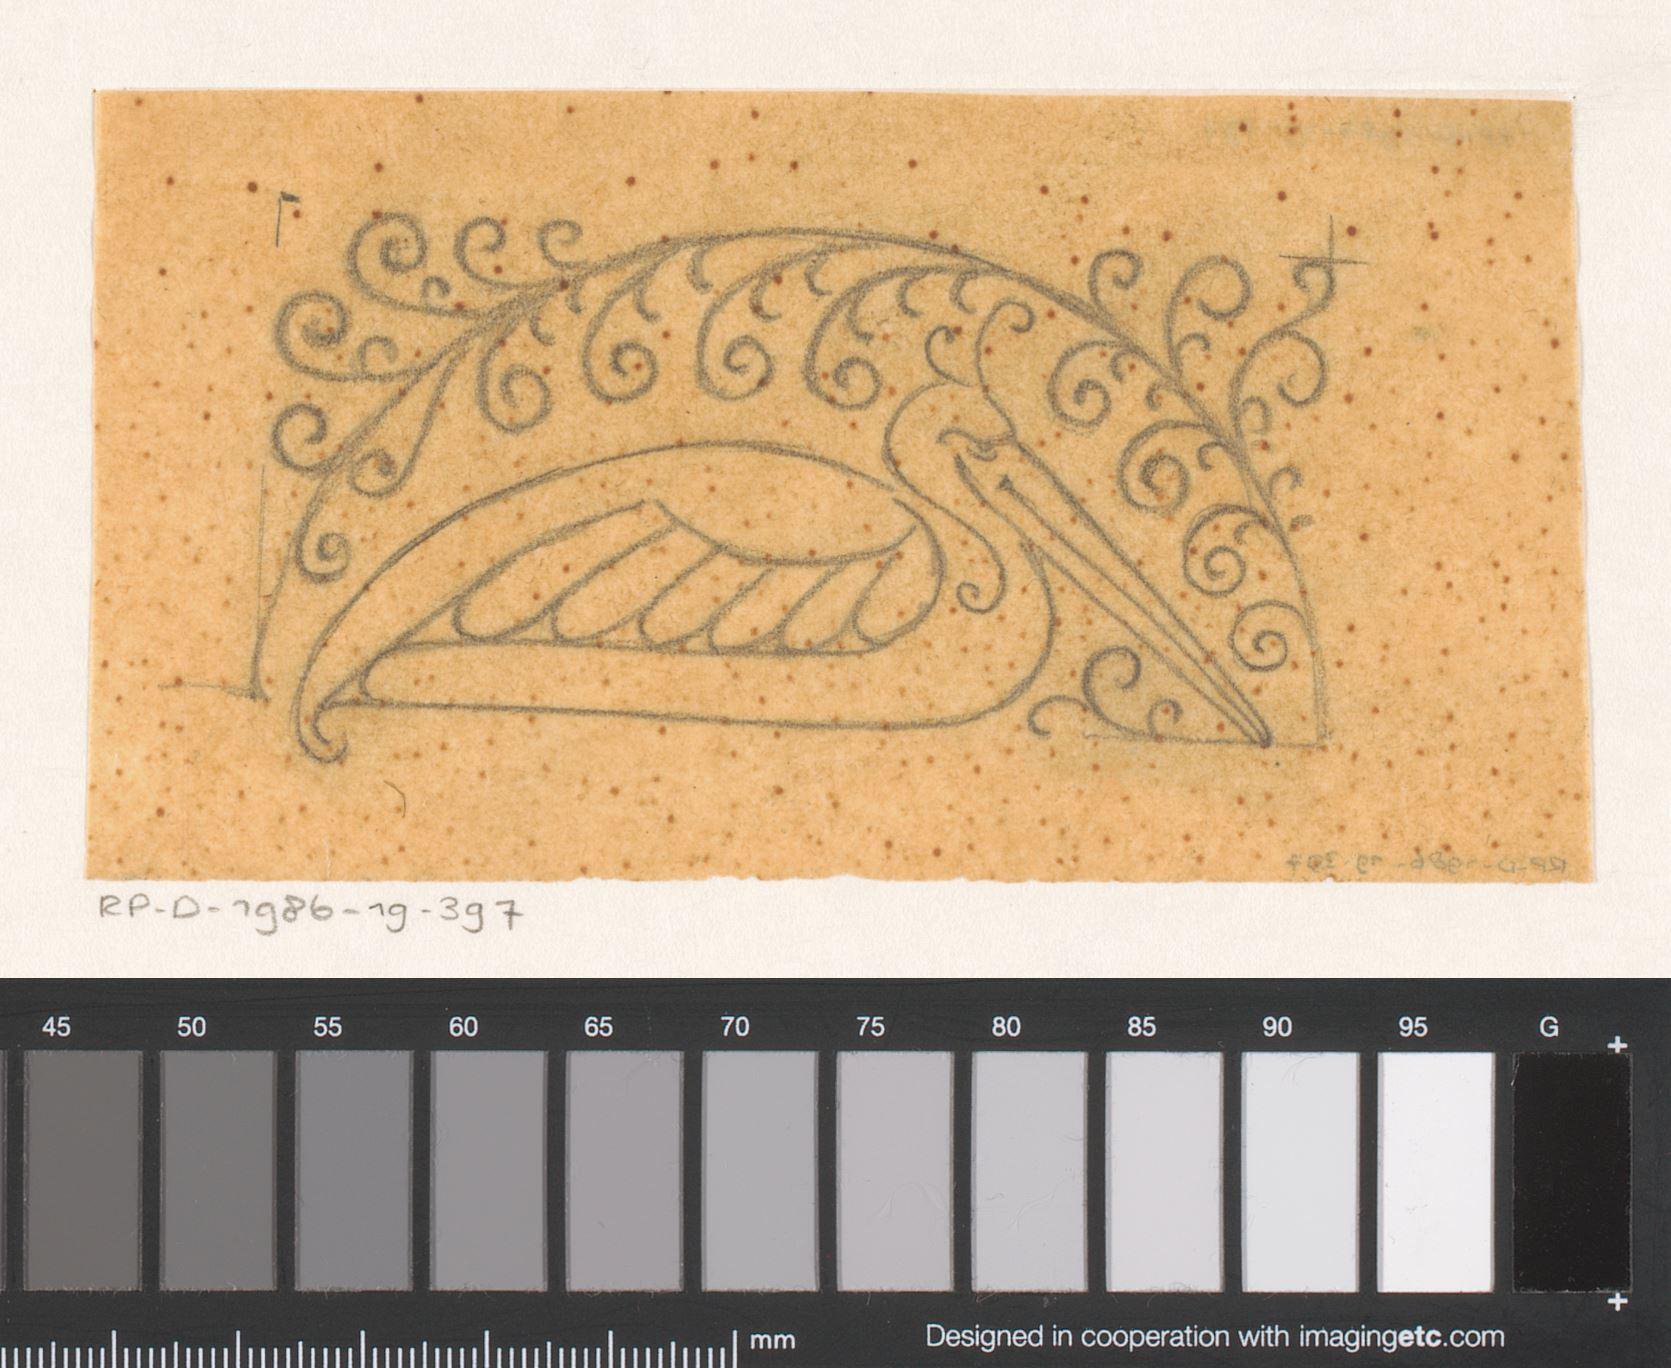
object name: drawing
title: Ornament met pelikaan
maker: reinier willem petrus de vries (1874-1953)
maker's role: draughtsman, print maker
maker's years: 1874-1953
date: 1884-1952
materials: pencil, paper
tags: ornament derived from animal forms